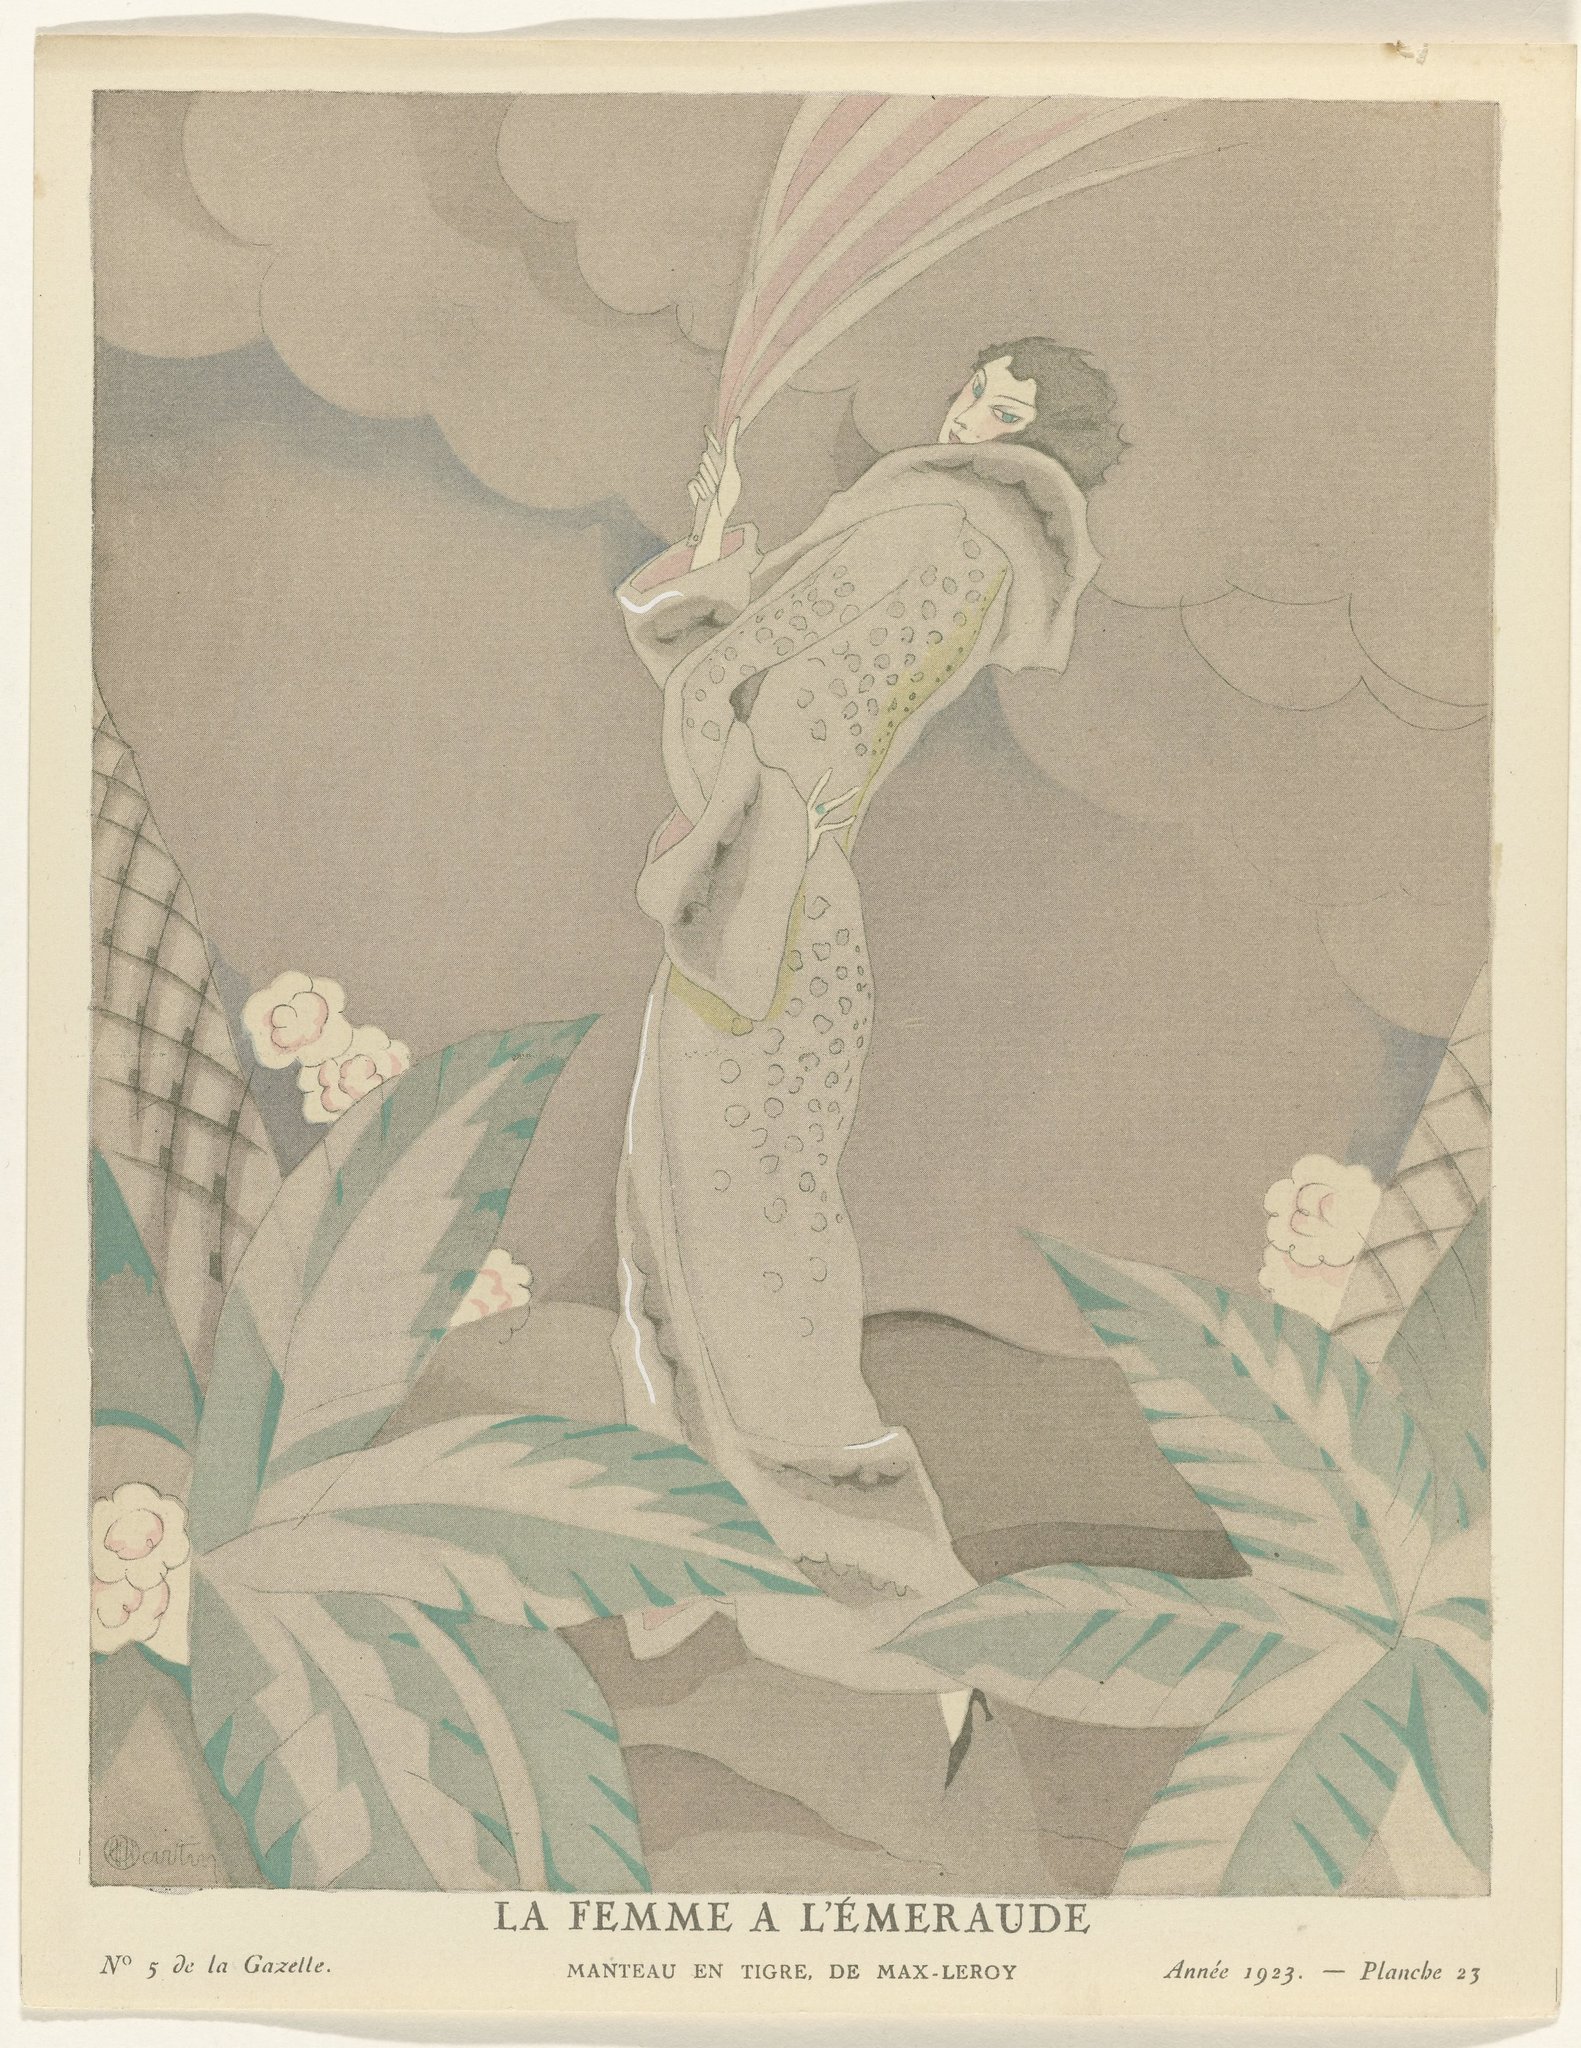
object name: fashion print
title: Gazette du Bon Ton. Art- Modes & Frivolités, 1923 - No. 5 : La femme a l'émeraude / Manteau en tigre, de Max-Leroy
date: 1923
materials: paper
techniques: hand coloring, letterpress printing, photochemical processes, pochoir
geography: paris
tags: coat (+ fur used for clothes), shrubs, coat (+ women's clothes), fashion plates, fan (+ women's clothes)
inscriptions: date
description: Lopende vrouw langs grote planten, op de rug gezien, gekleed in een mantel van tijgerbont van Max-Leroy. In de rechterhand een grote waaier van veren. Planche 23 uit Gazette du Bon Ton 1923, No. 5.